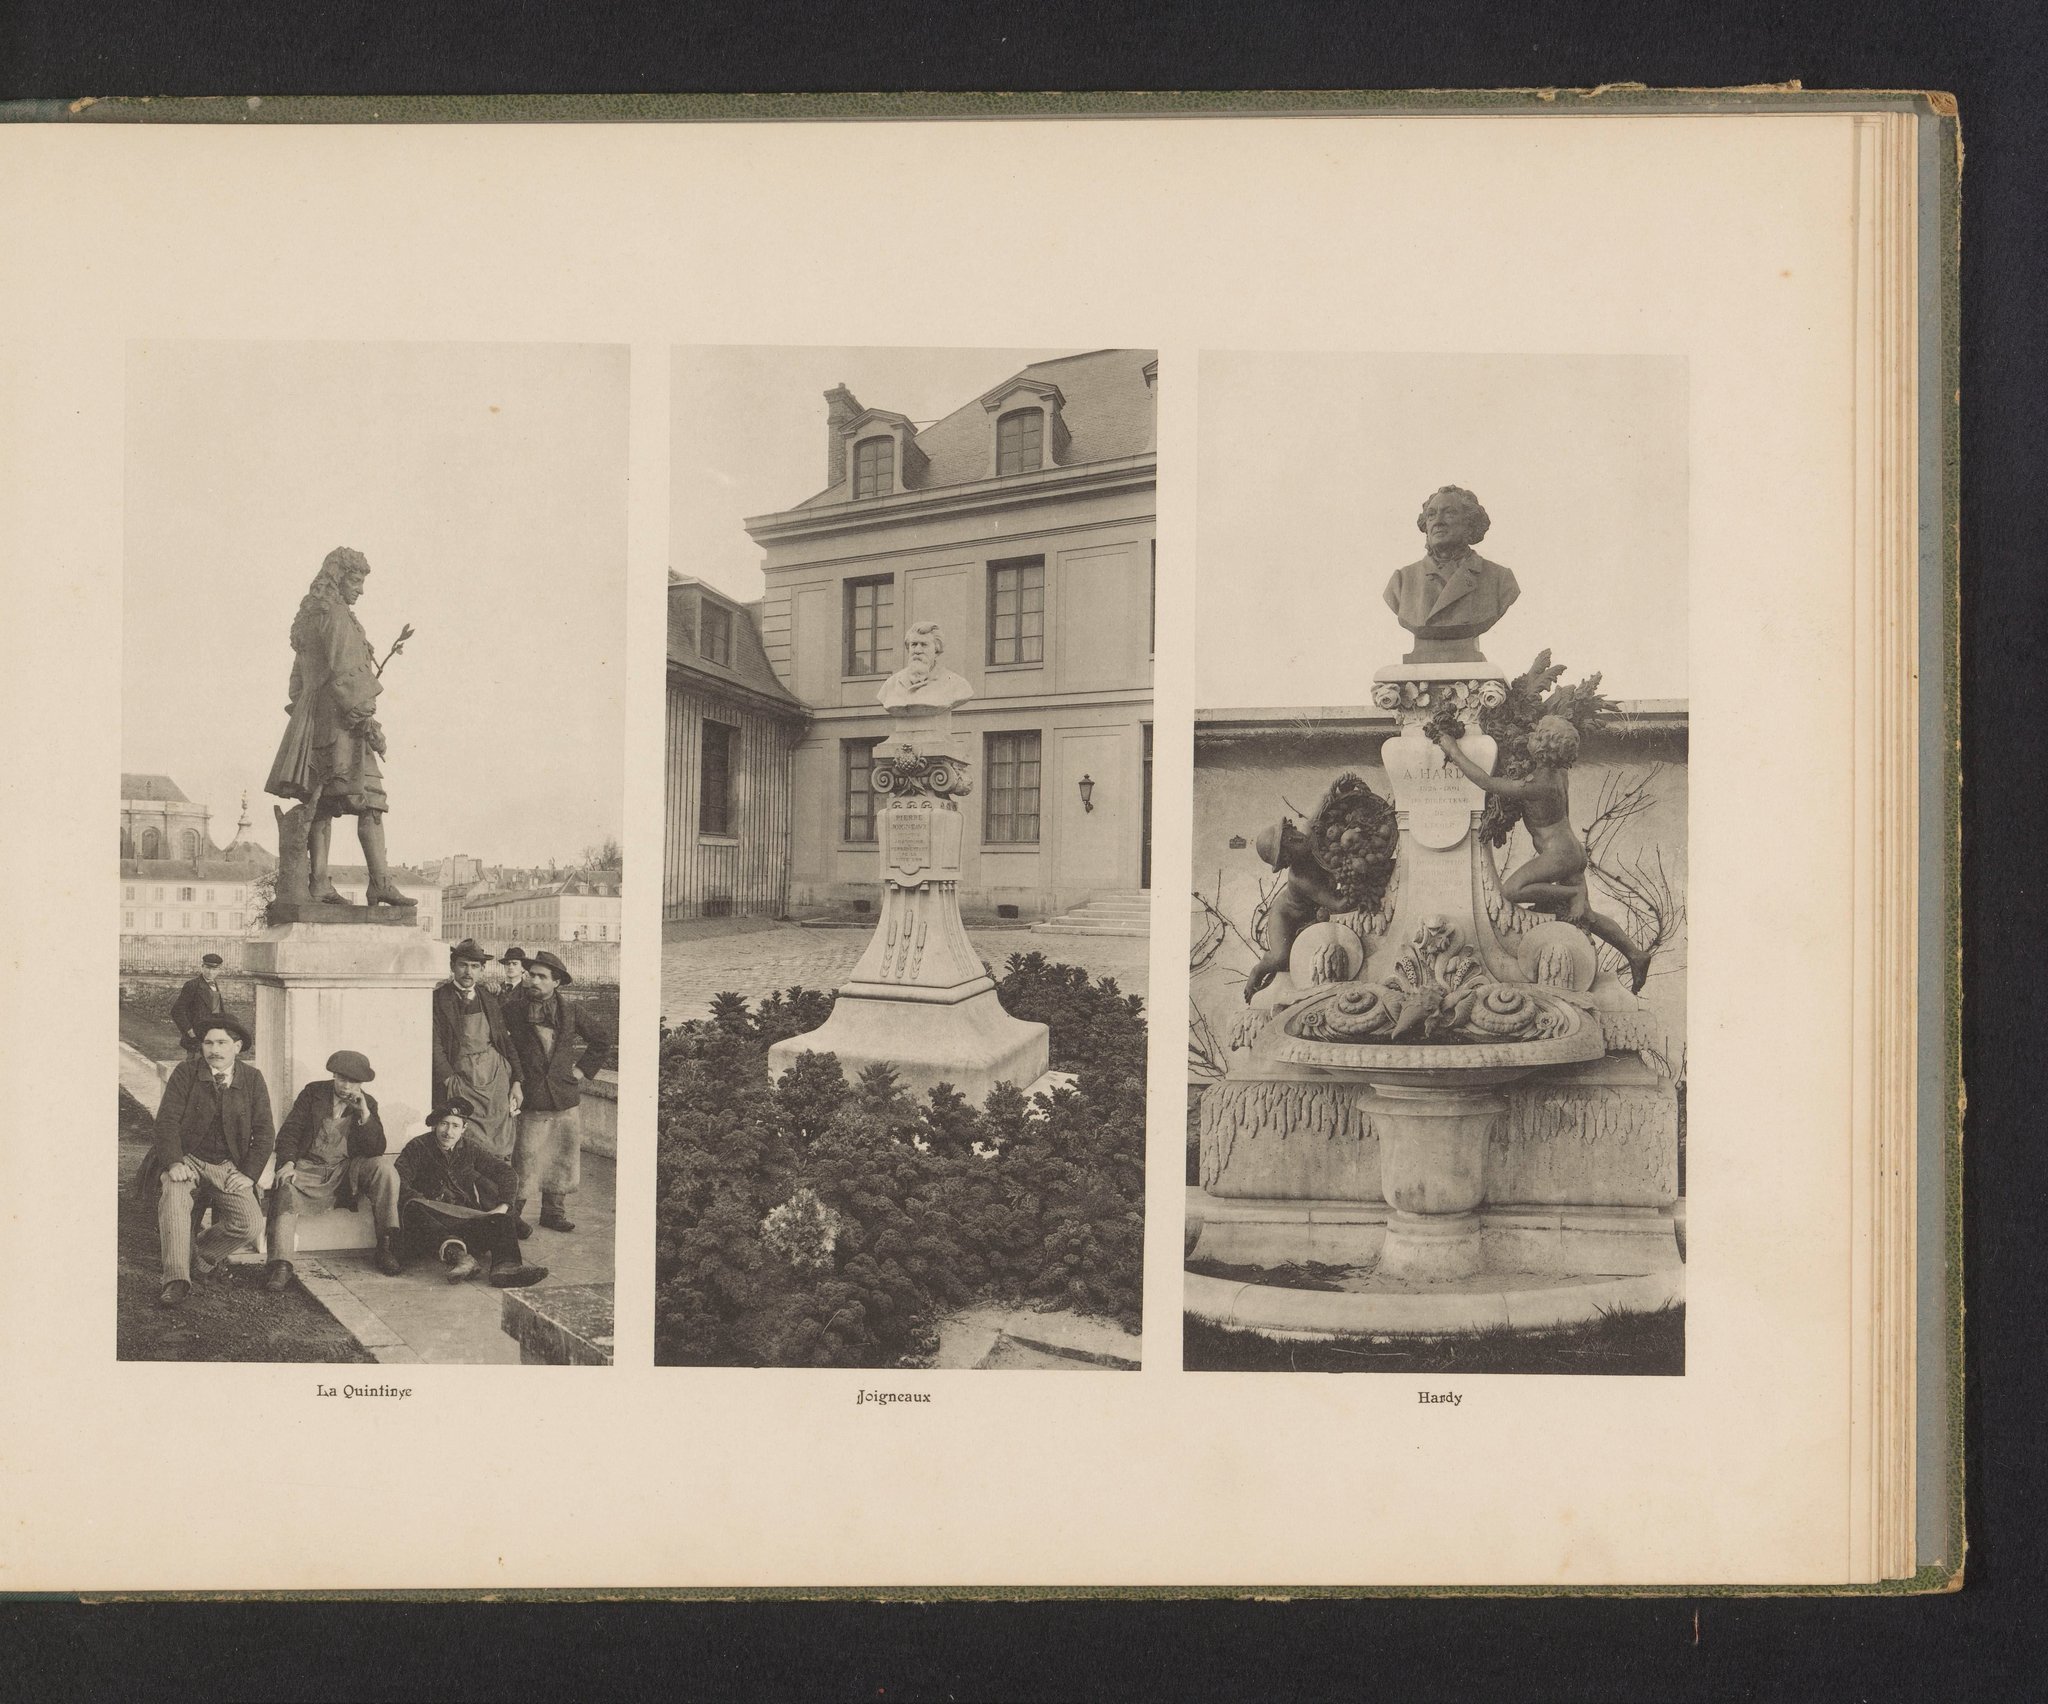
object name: page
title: Joigneaux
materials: paper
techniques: photograph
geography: versailles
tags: horticulture, vegetable culture, market gardening, piece of sculpture, reproduction of a piece of sculpture, botanic garden, 'hortus botanicus'